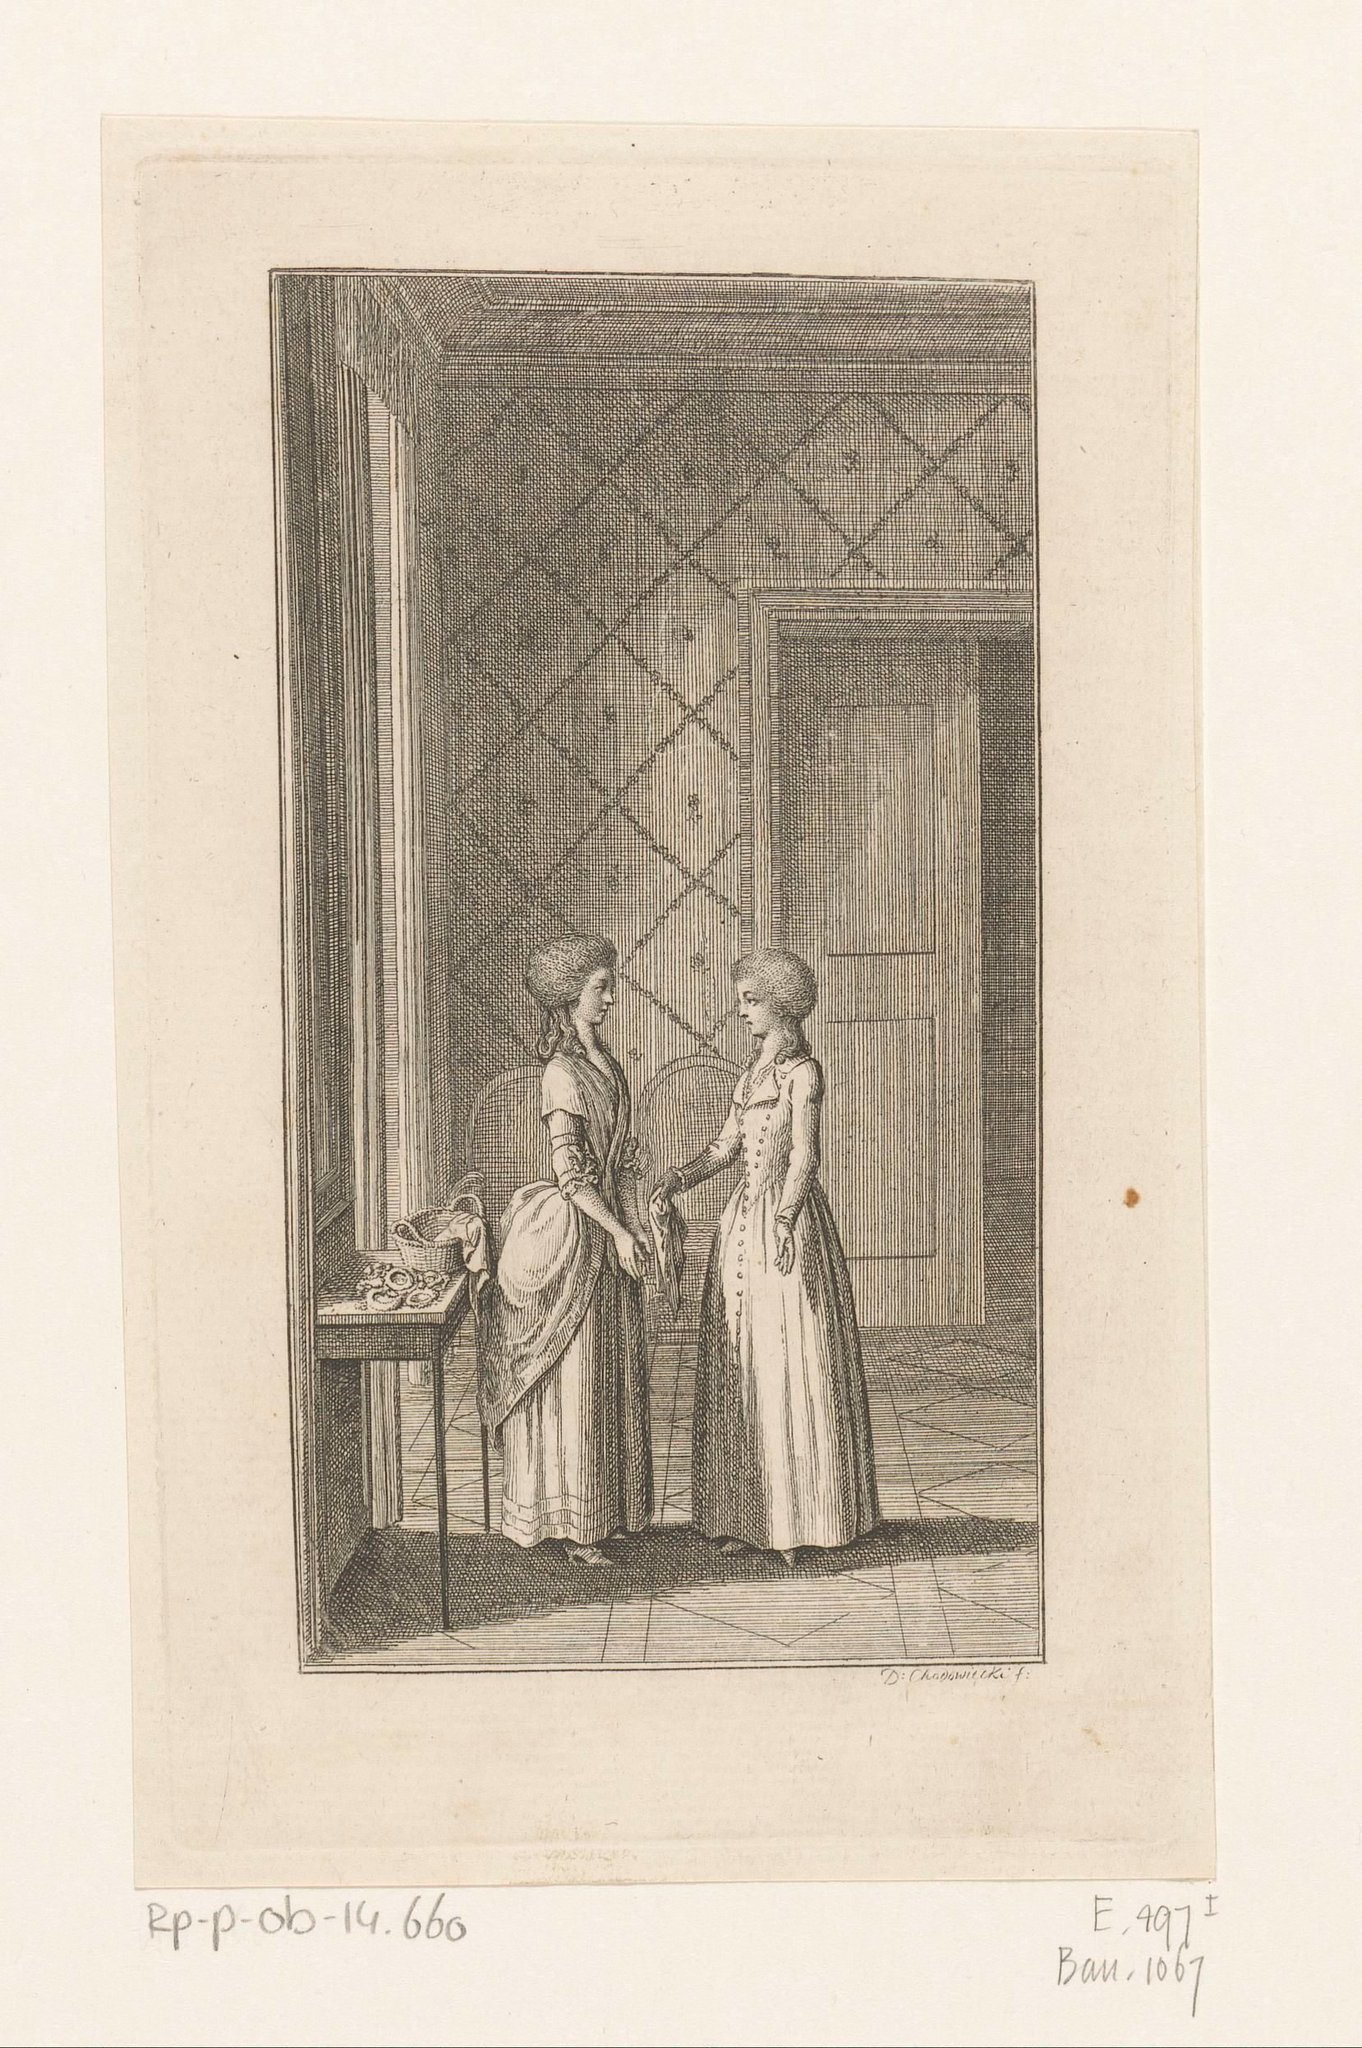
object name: print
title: Marianchen verstopt het suikergoed voor Hannchen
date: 1784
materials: paper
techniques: etching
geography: leipzig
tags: adolescent, young woman, maiden, literature, interior of the house, dishonesty, falsety, hiding, concealing, burying a treasure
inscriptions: collector's mark: Lugt 2228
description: Prent uit: Weisse, Christian Felix. Briefwechsel der Familie des Kinderfreundes. Leipzig: bei Siegfried Lebrecht Crusius, 1784.